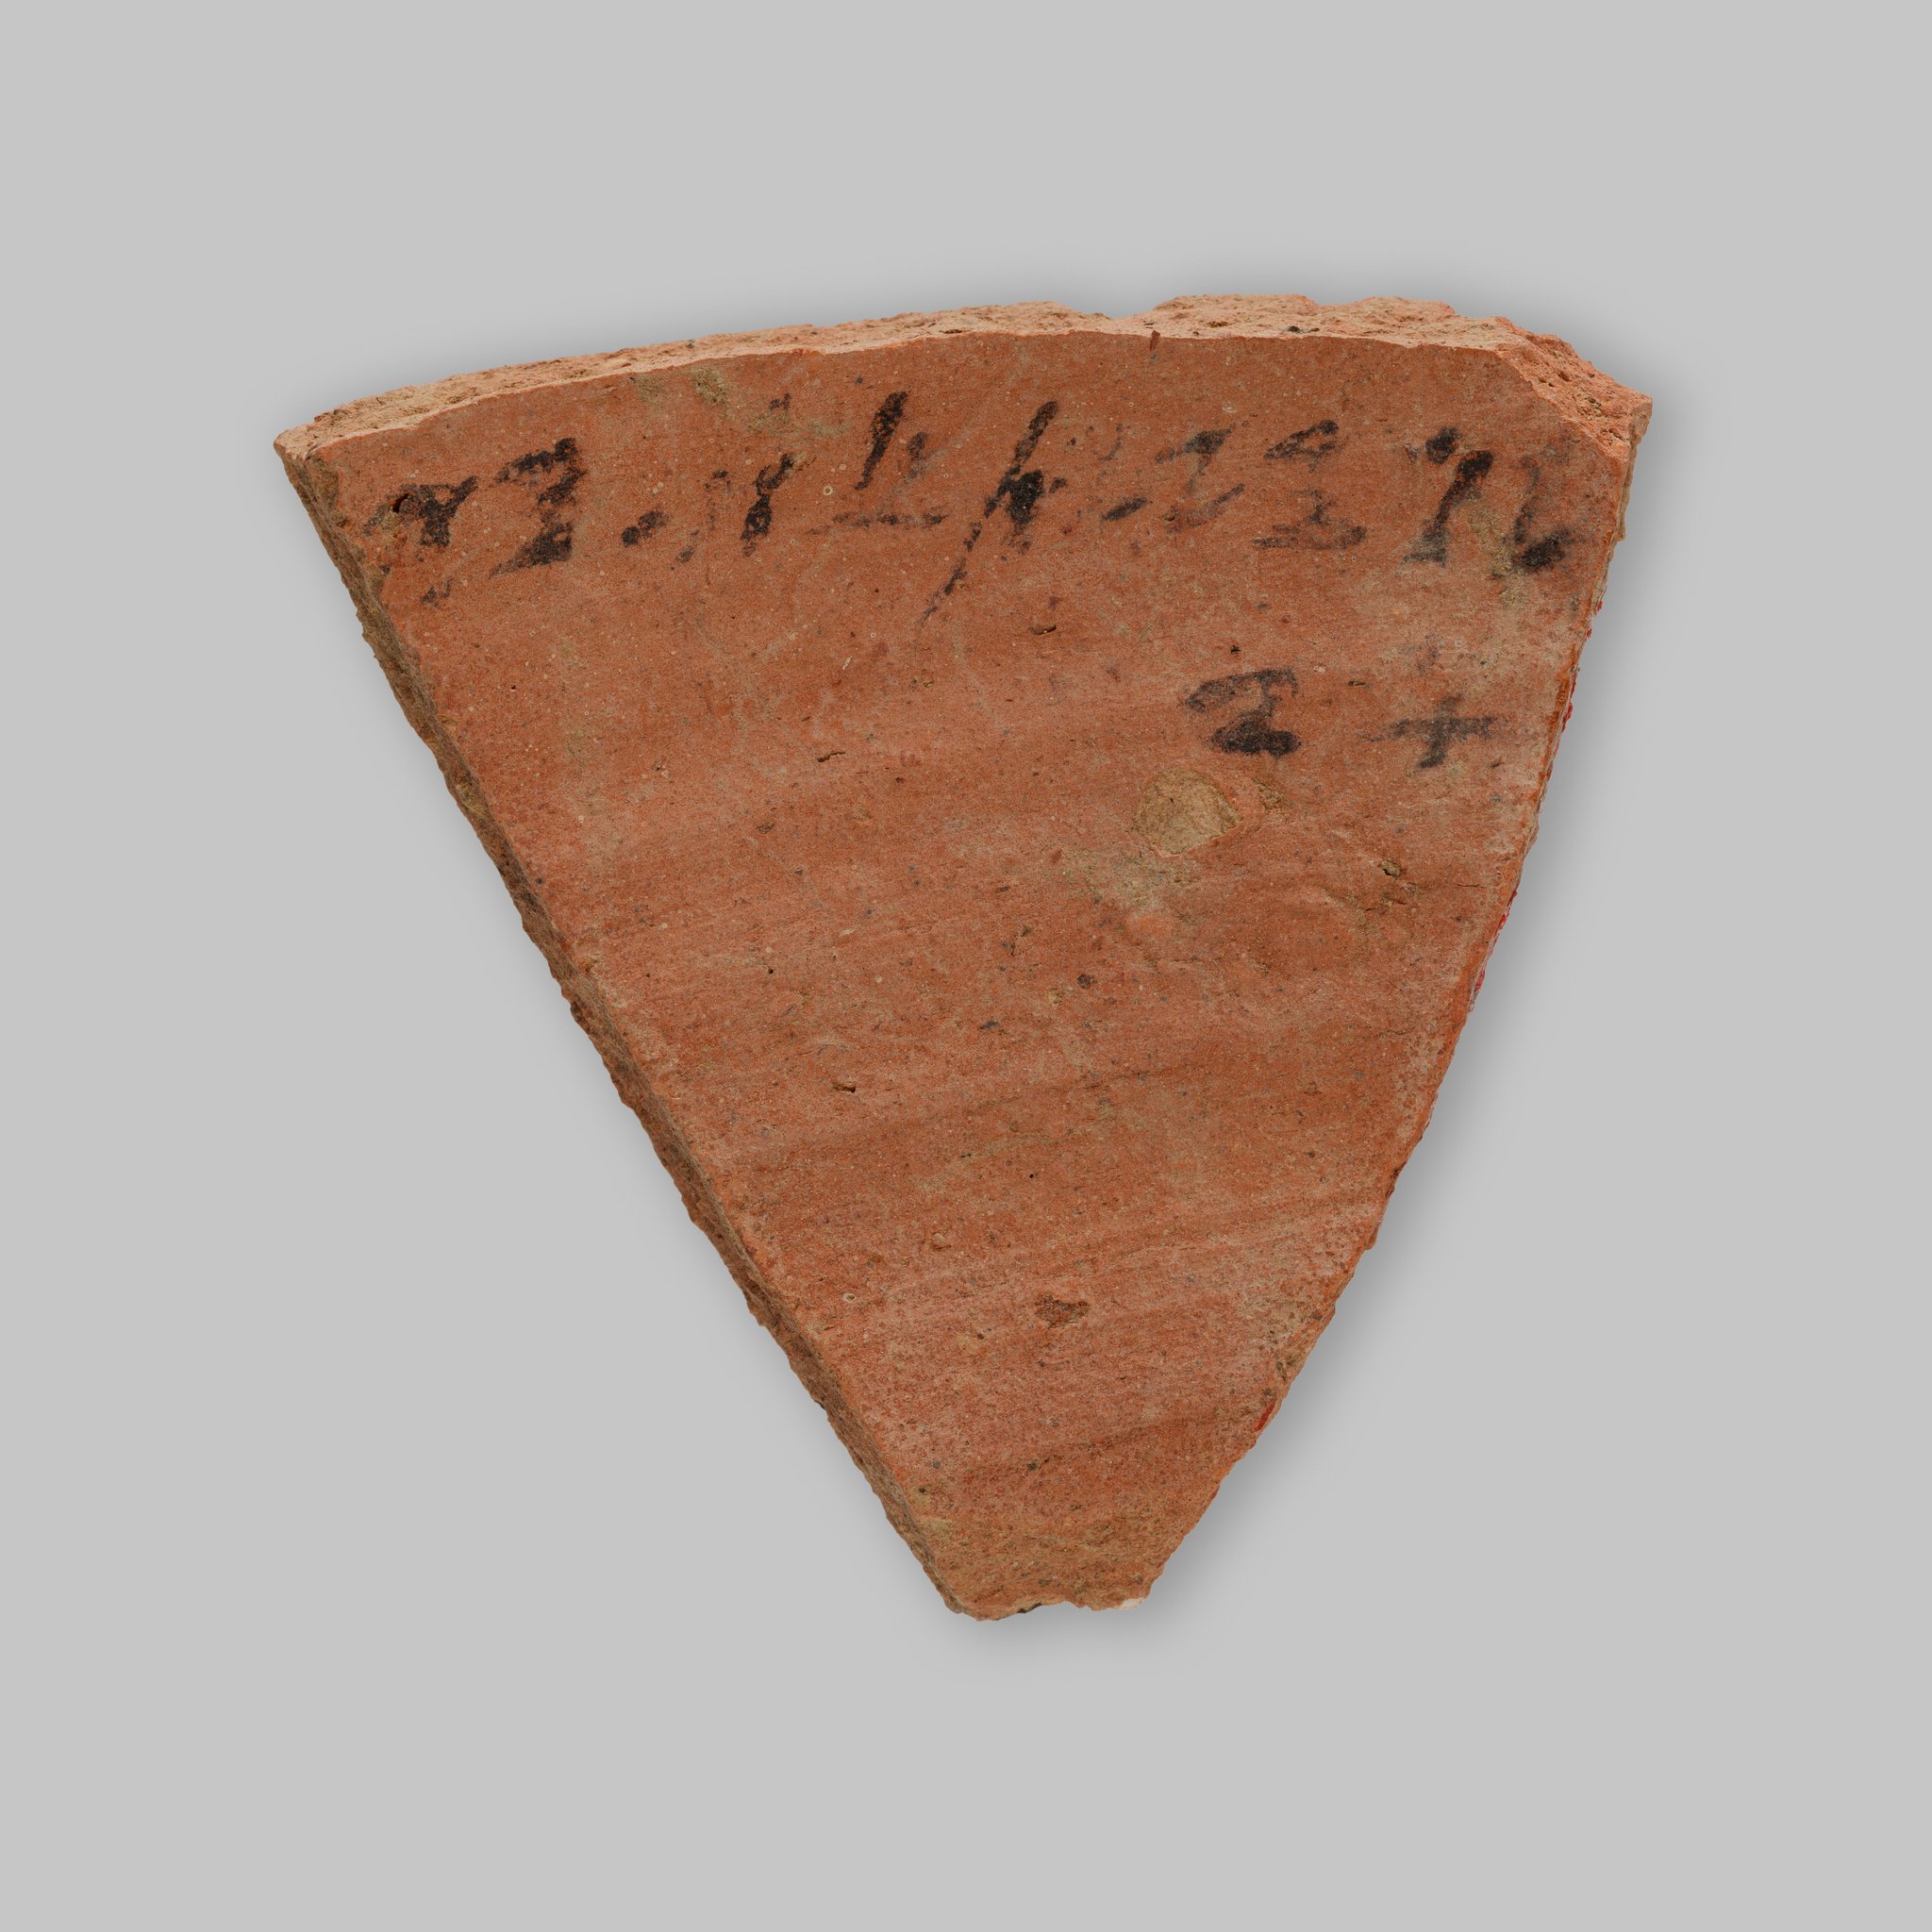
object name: ostracon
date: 595-530 BCE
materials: ink, pottery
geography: egypt